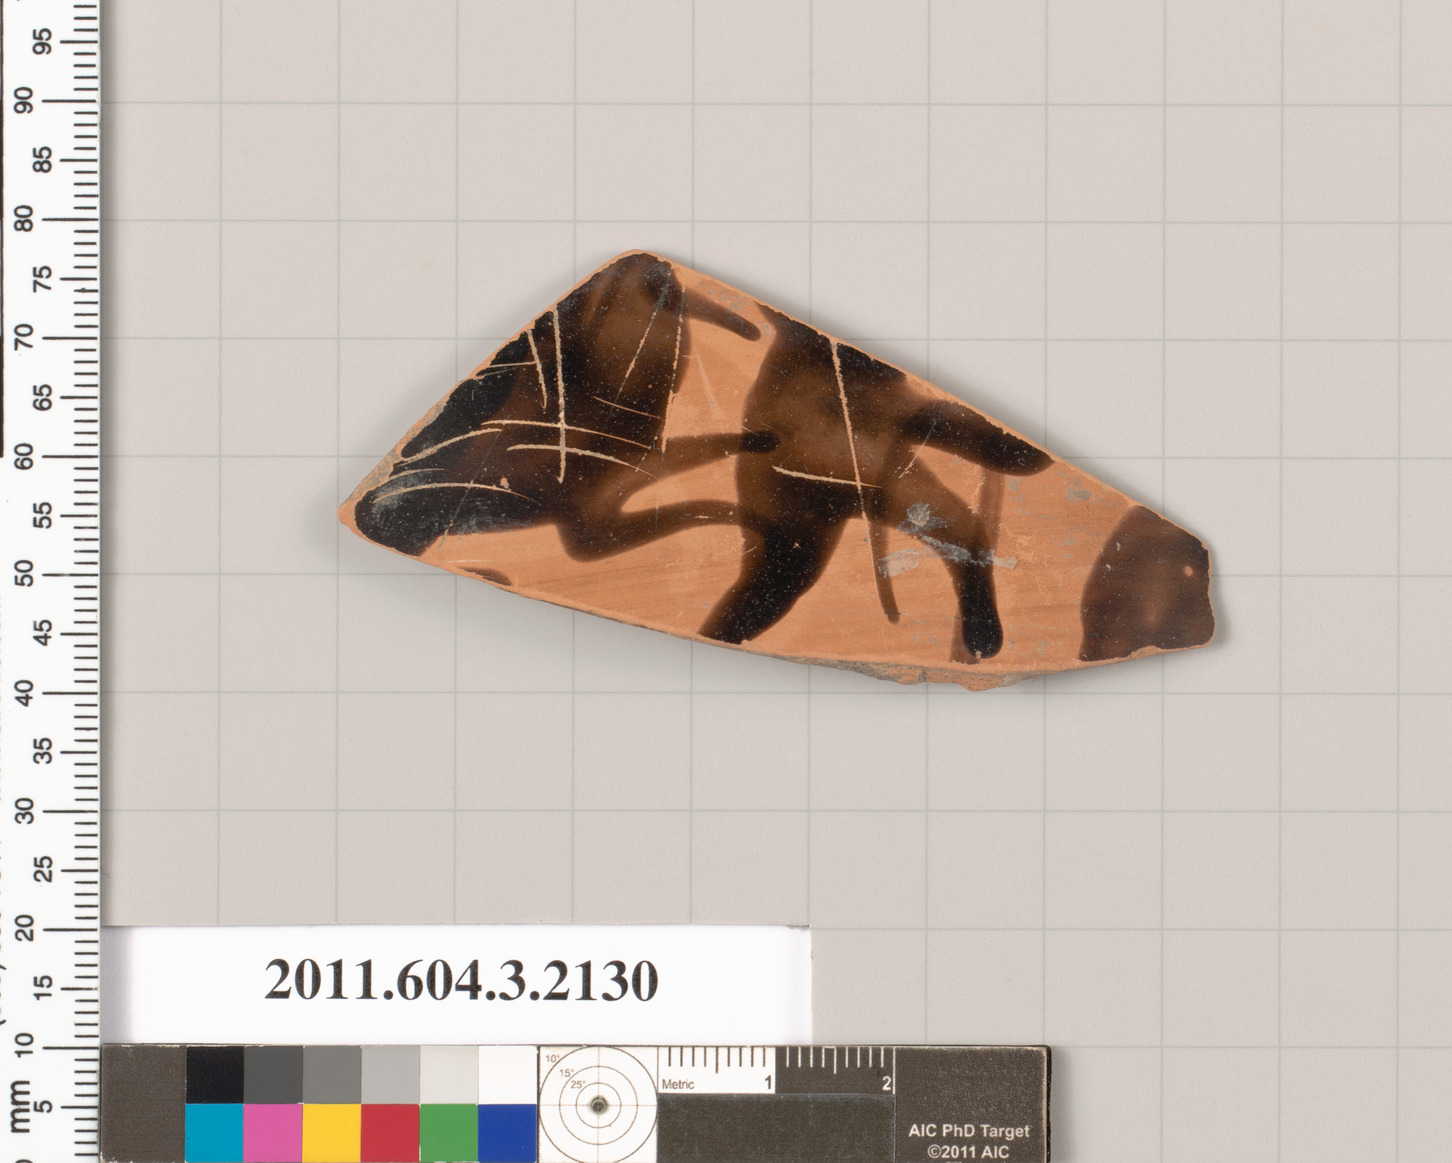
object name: kylix fragment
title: Terracotta fragment of a kylix (drinking cup)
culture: greek, attic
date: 500-468 BCE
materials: terracotta